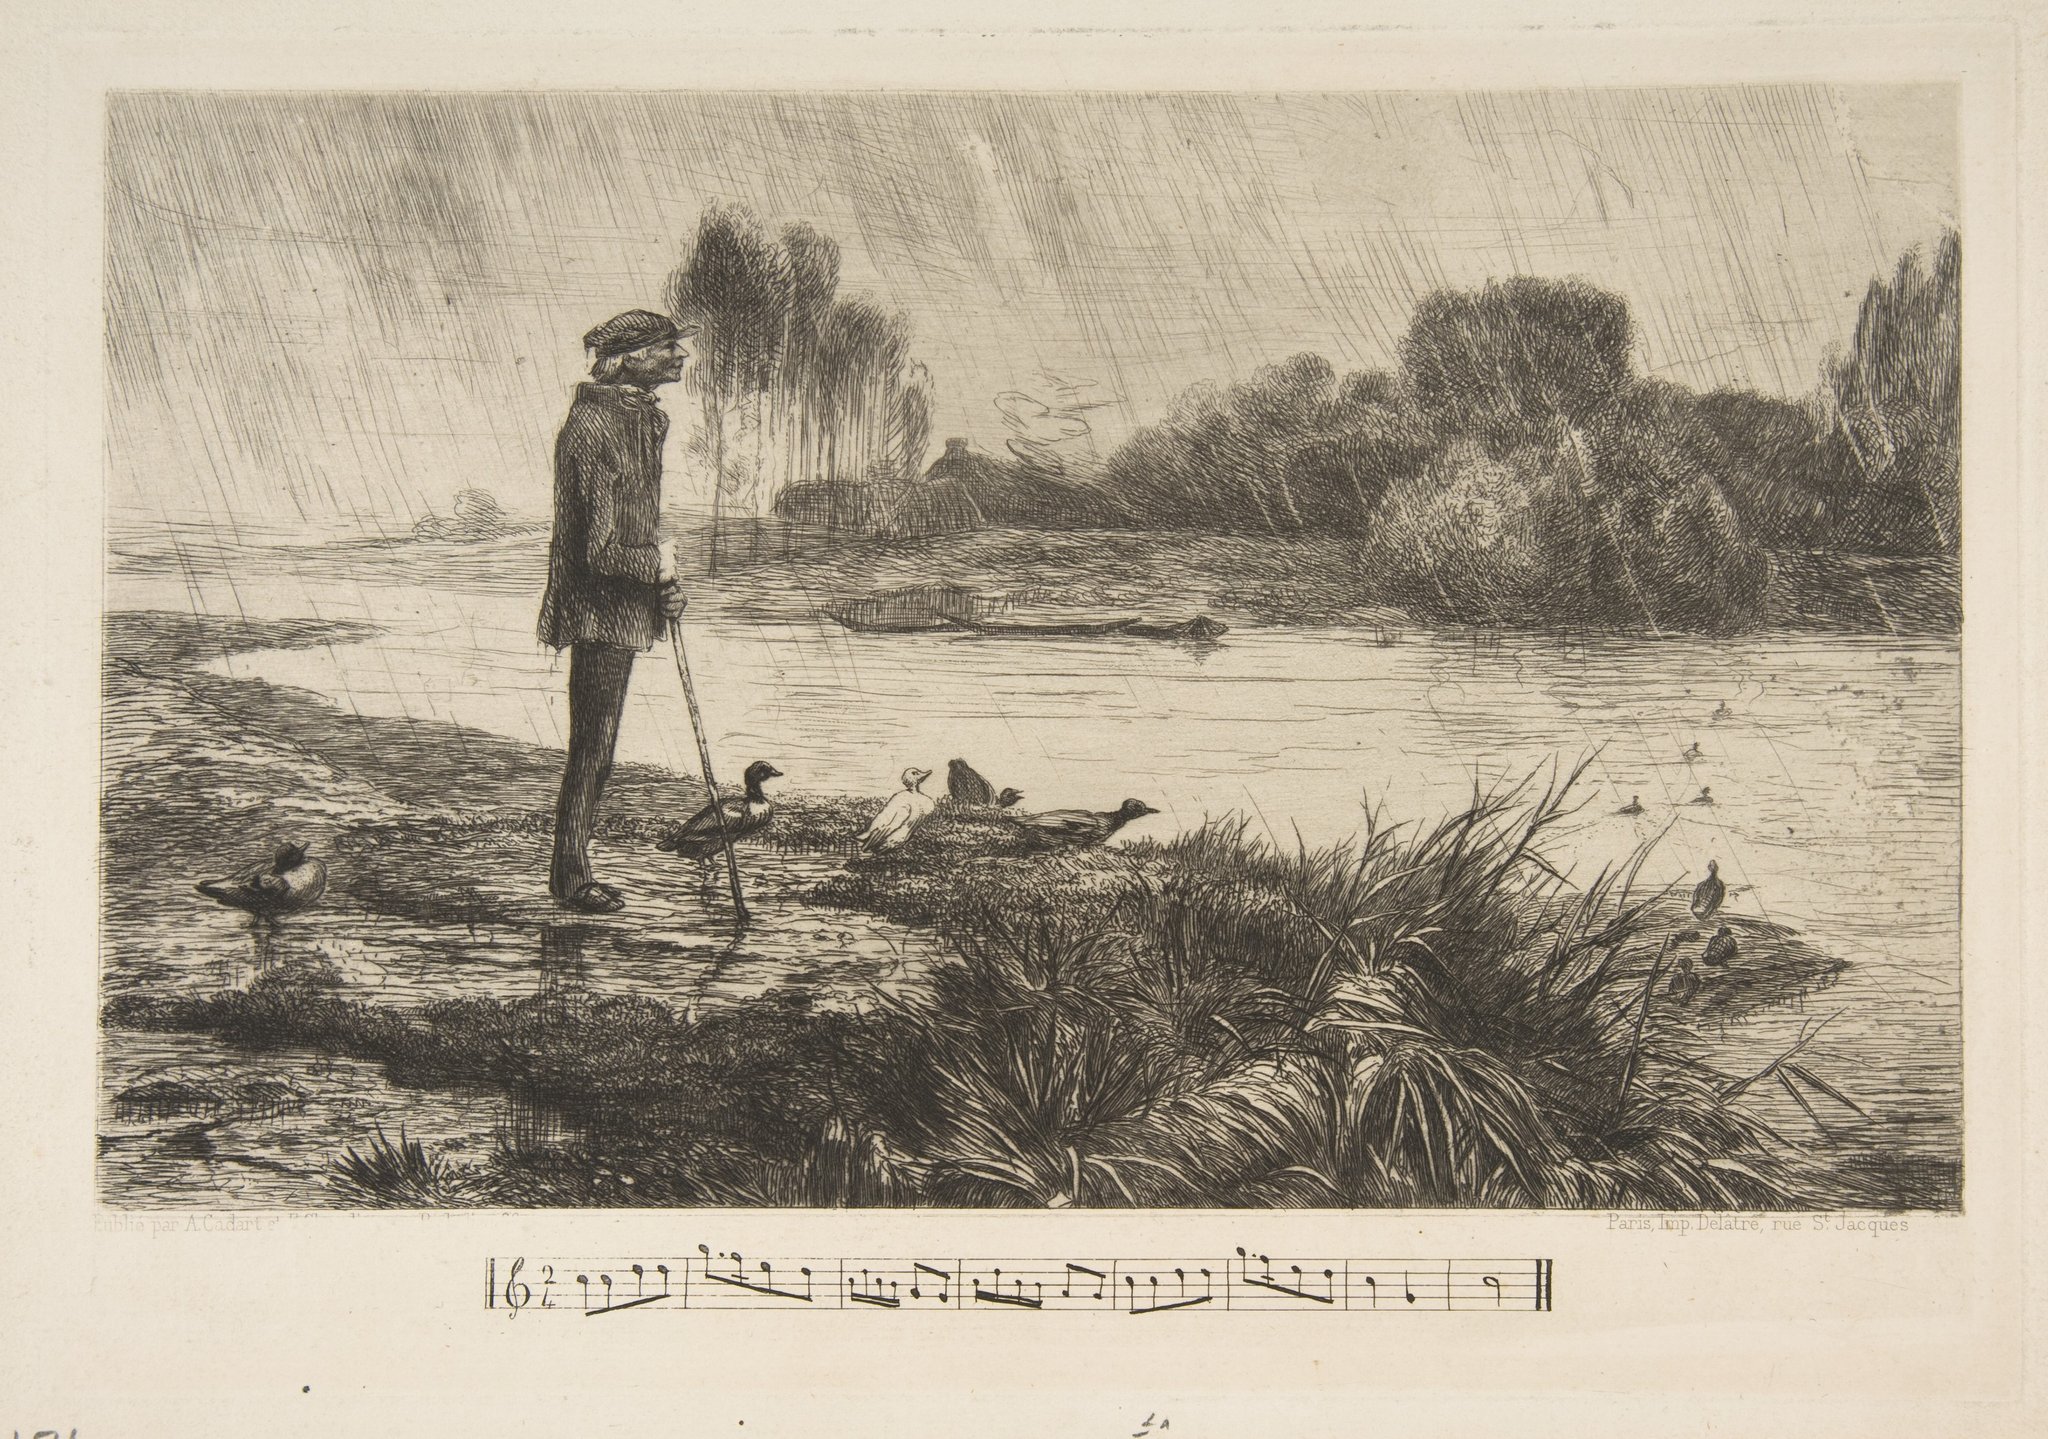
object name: print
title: Les Canards l'ont bien passée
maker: félix bracquemond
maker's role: artist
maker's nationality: french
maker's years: 1833-1914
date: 1856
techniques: etching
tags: ducks,men,rain